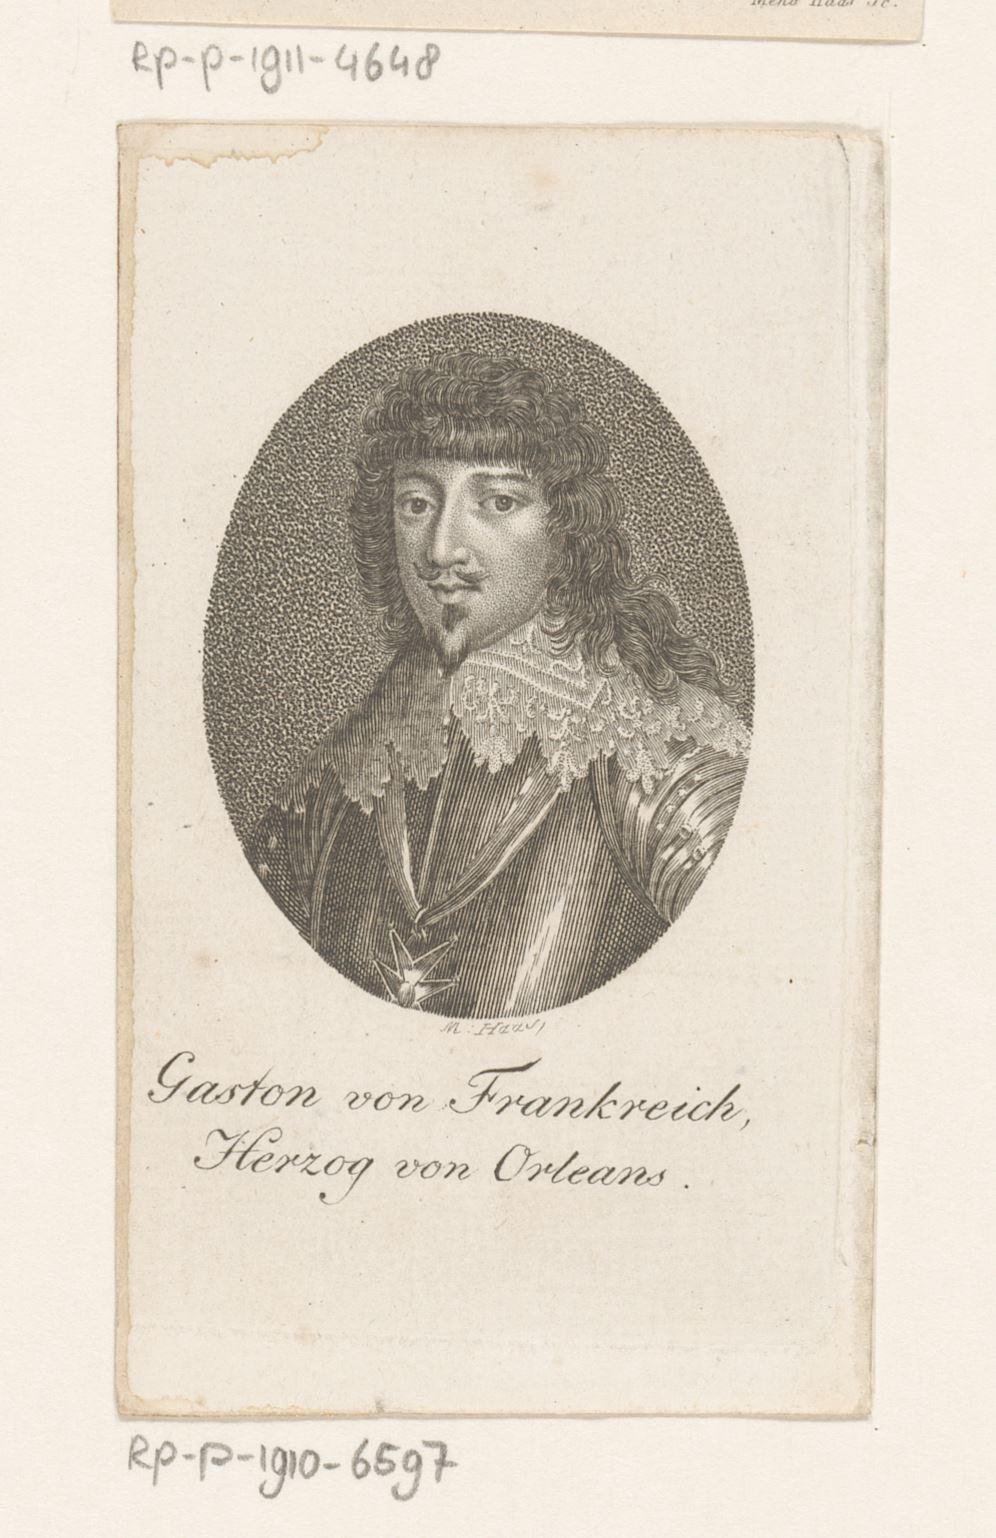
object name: print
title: Portret van Gaston Jean-Baptiste hertog van Orléans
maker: meno haas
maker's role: print maker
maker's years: 1752-1833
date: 1762-1833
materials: paper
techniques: engraving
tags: gaston jean-baptiste hertog van orléans, armour, historical persons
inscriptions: collector's mark: Lugt 2228